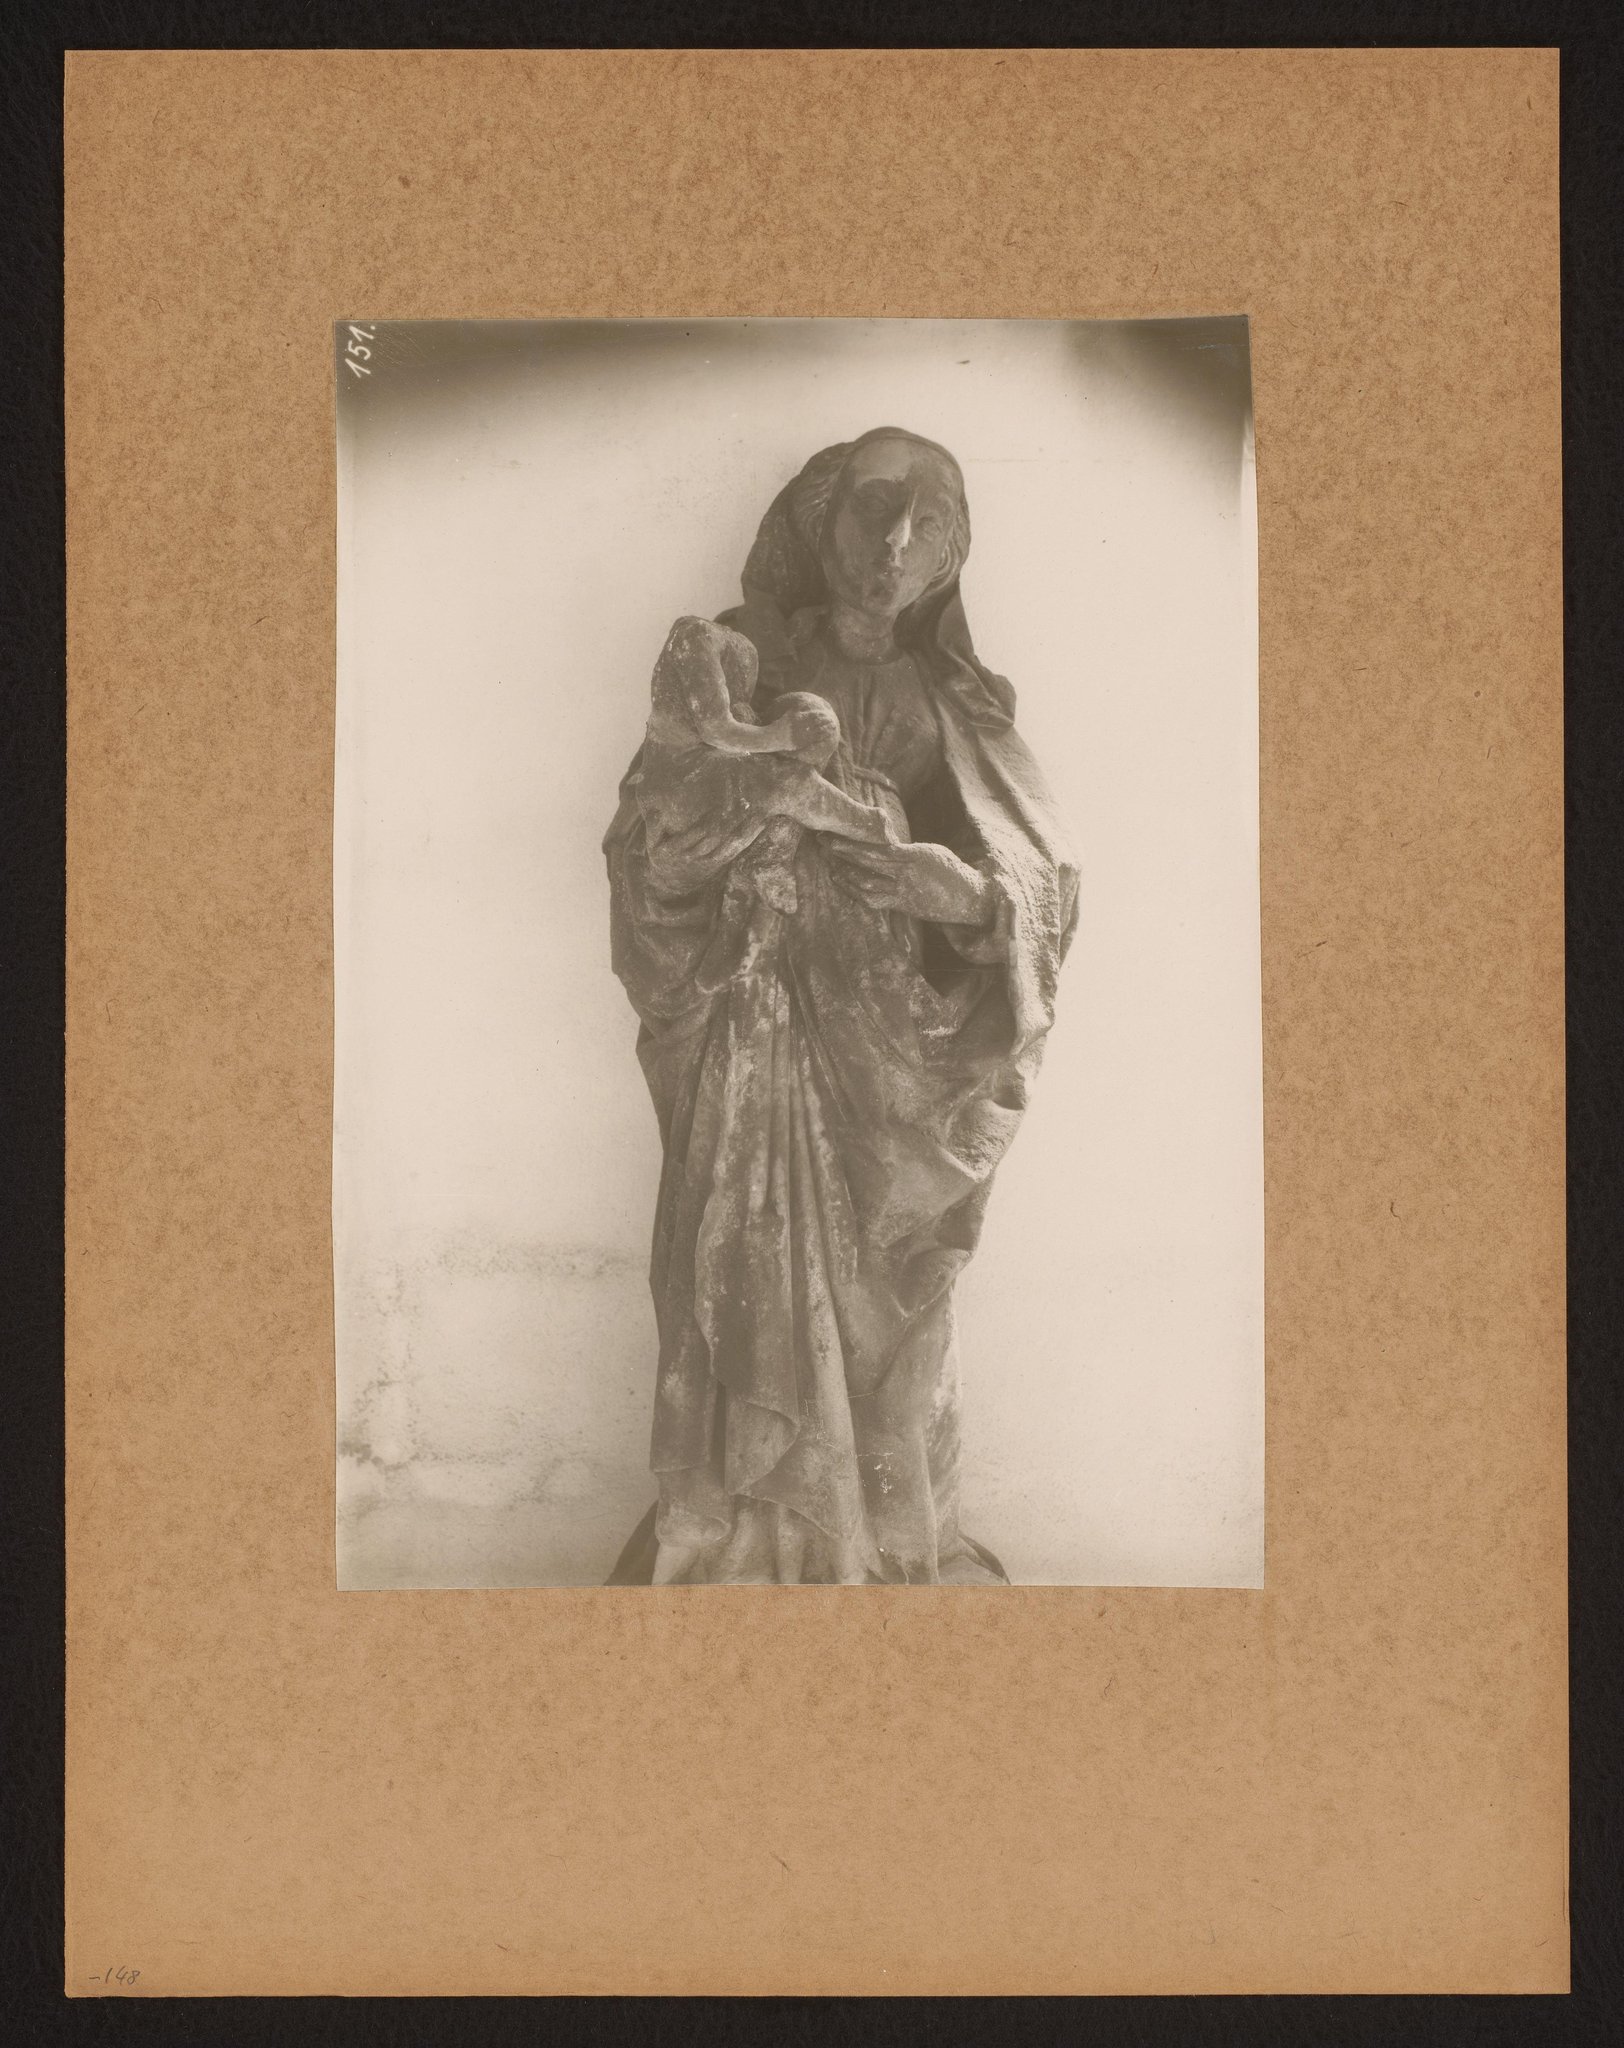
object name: album leaf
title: Kreuzgang, Madonna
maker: Anonymous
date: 1900-1920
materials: paper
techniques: gelatin silver print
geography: bamberg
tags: interior of church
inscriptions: number: ‘151.’